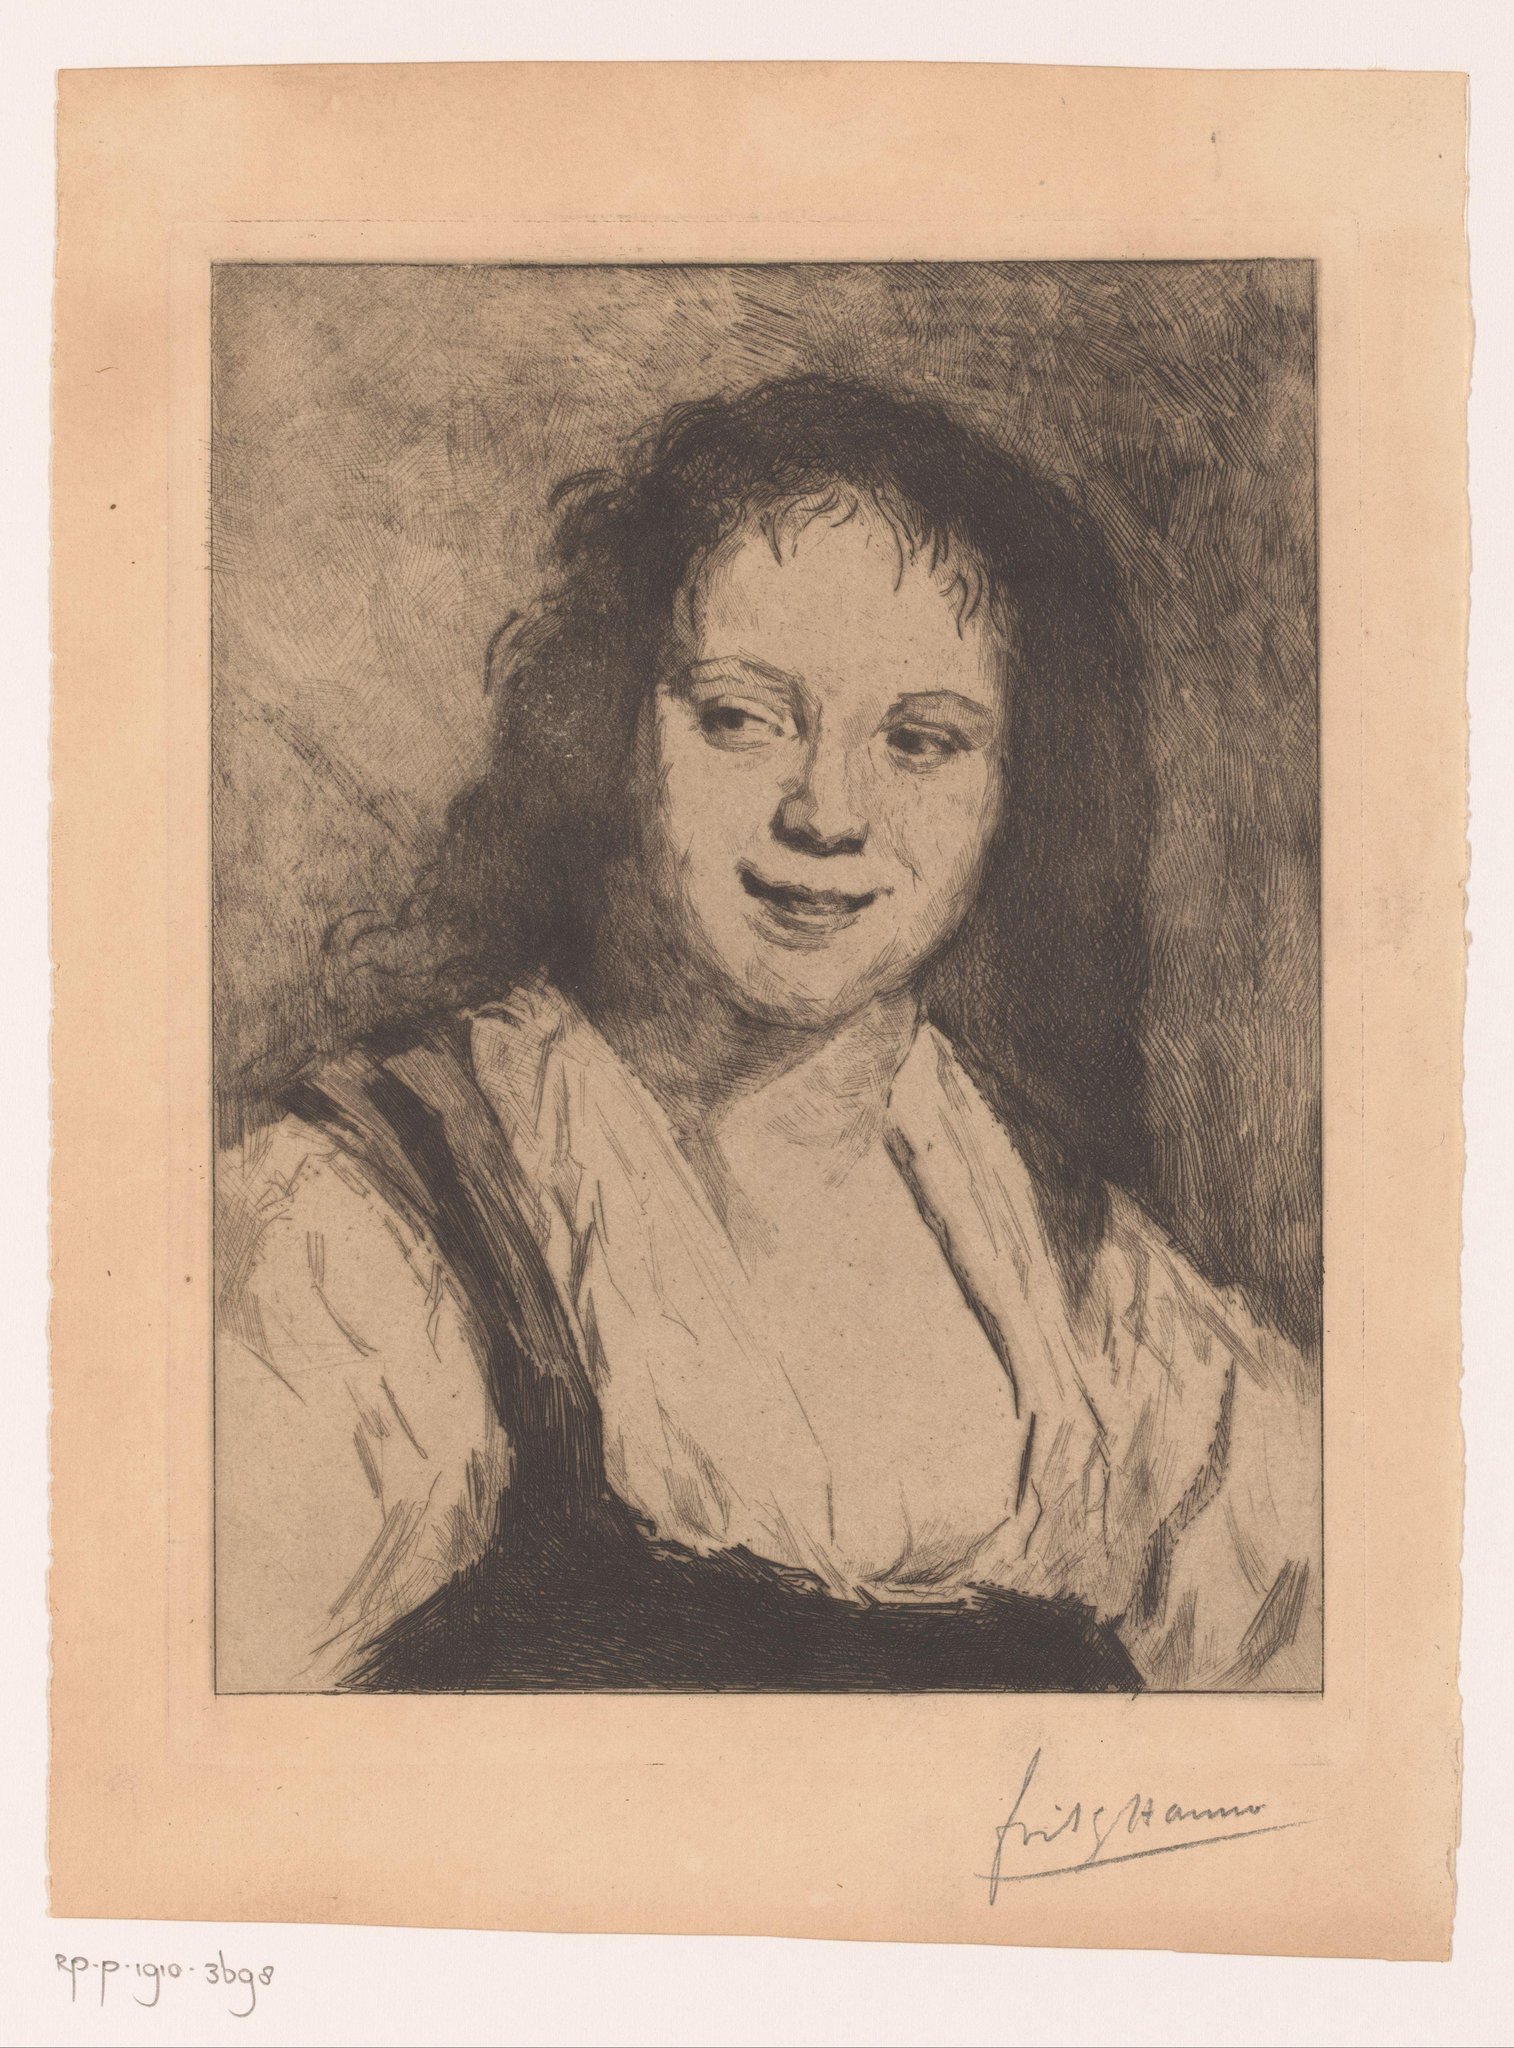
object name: print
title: Portret van een onbekende jonge vrouw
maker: fritz hanno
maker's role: print maker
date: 1880-1905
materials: paper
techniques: drypoint, etching, intaglio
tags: anonymous historical person portrayed alone - bb - woman, wandering communities: romani or roma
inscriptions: collector's mark: Lugt 2228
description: Proefdruk van een kopie in spiegelbeeld van het schilderij van Frans Hals dat ook bekend staat als Het zigeunermeisje. Sterfdatum prentmaker onbekend. Derhalve is voor bepaling van de rechten van dit object de verwervingsdatum aangehouden.